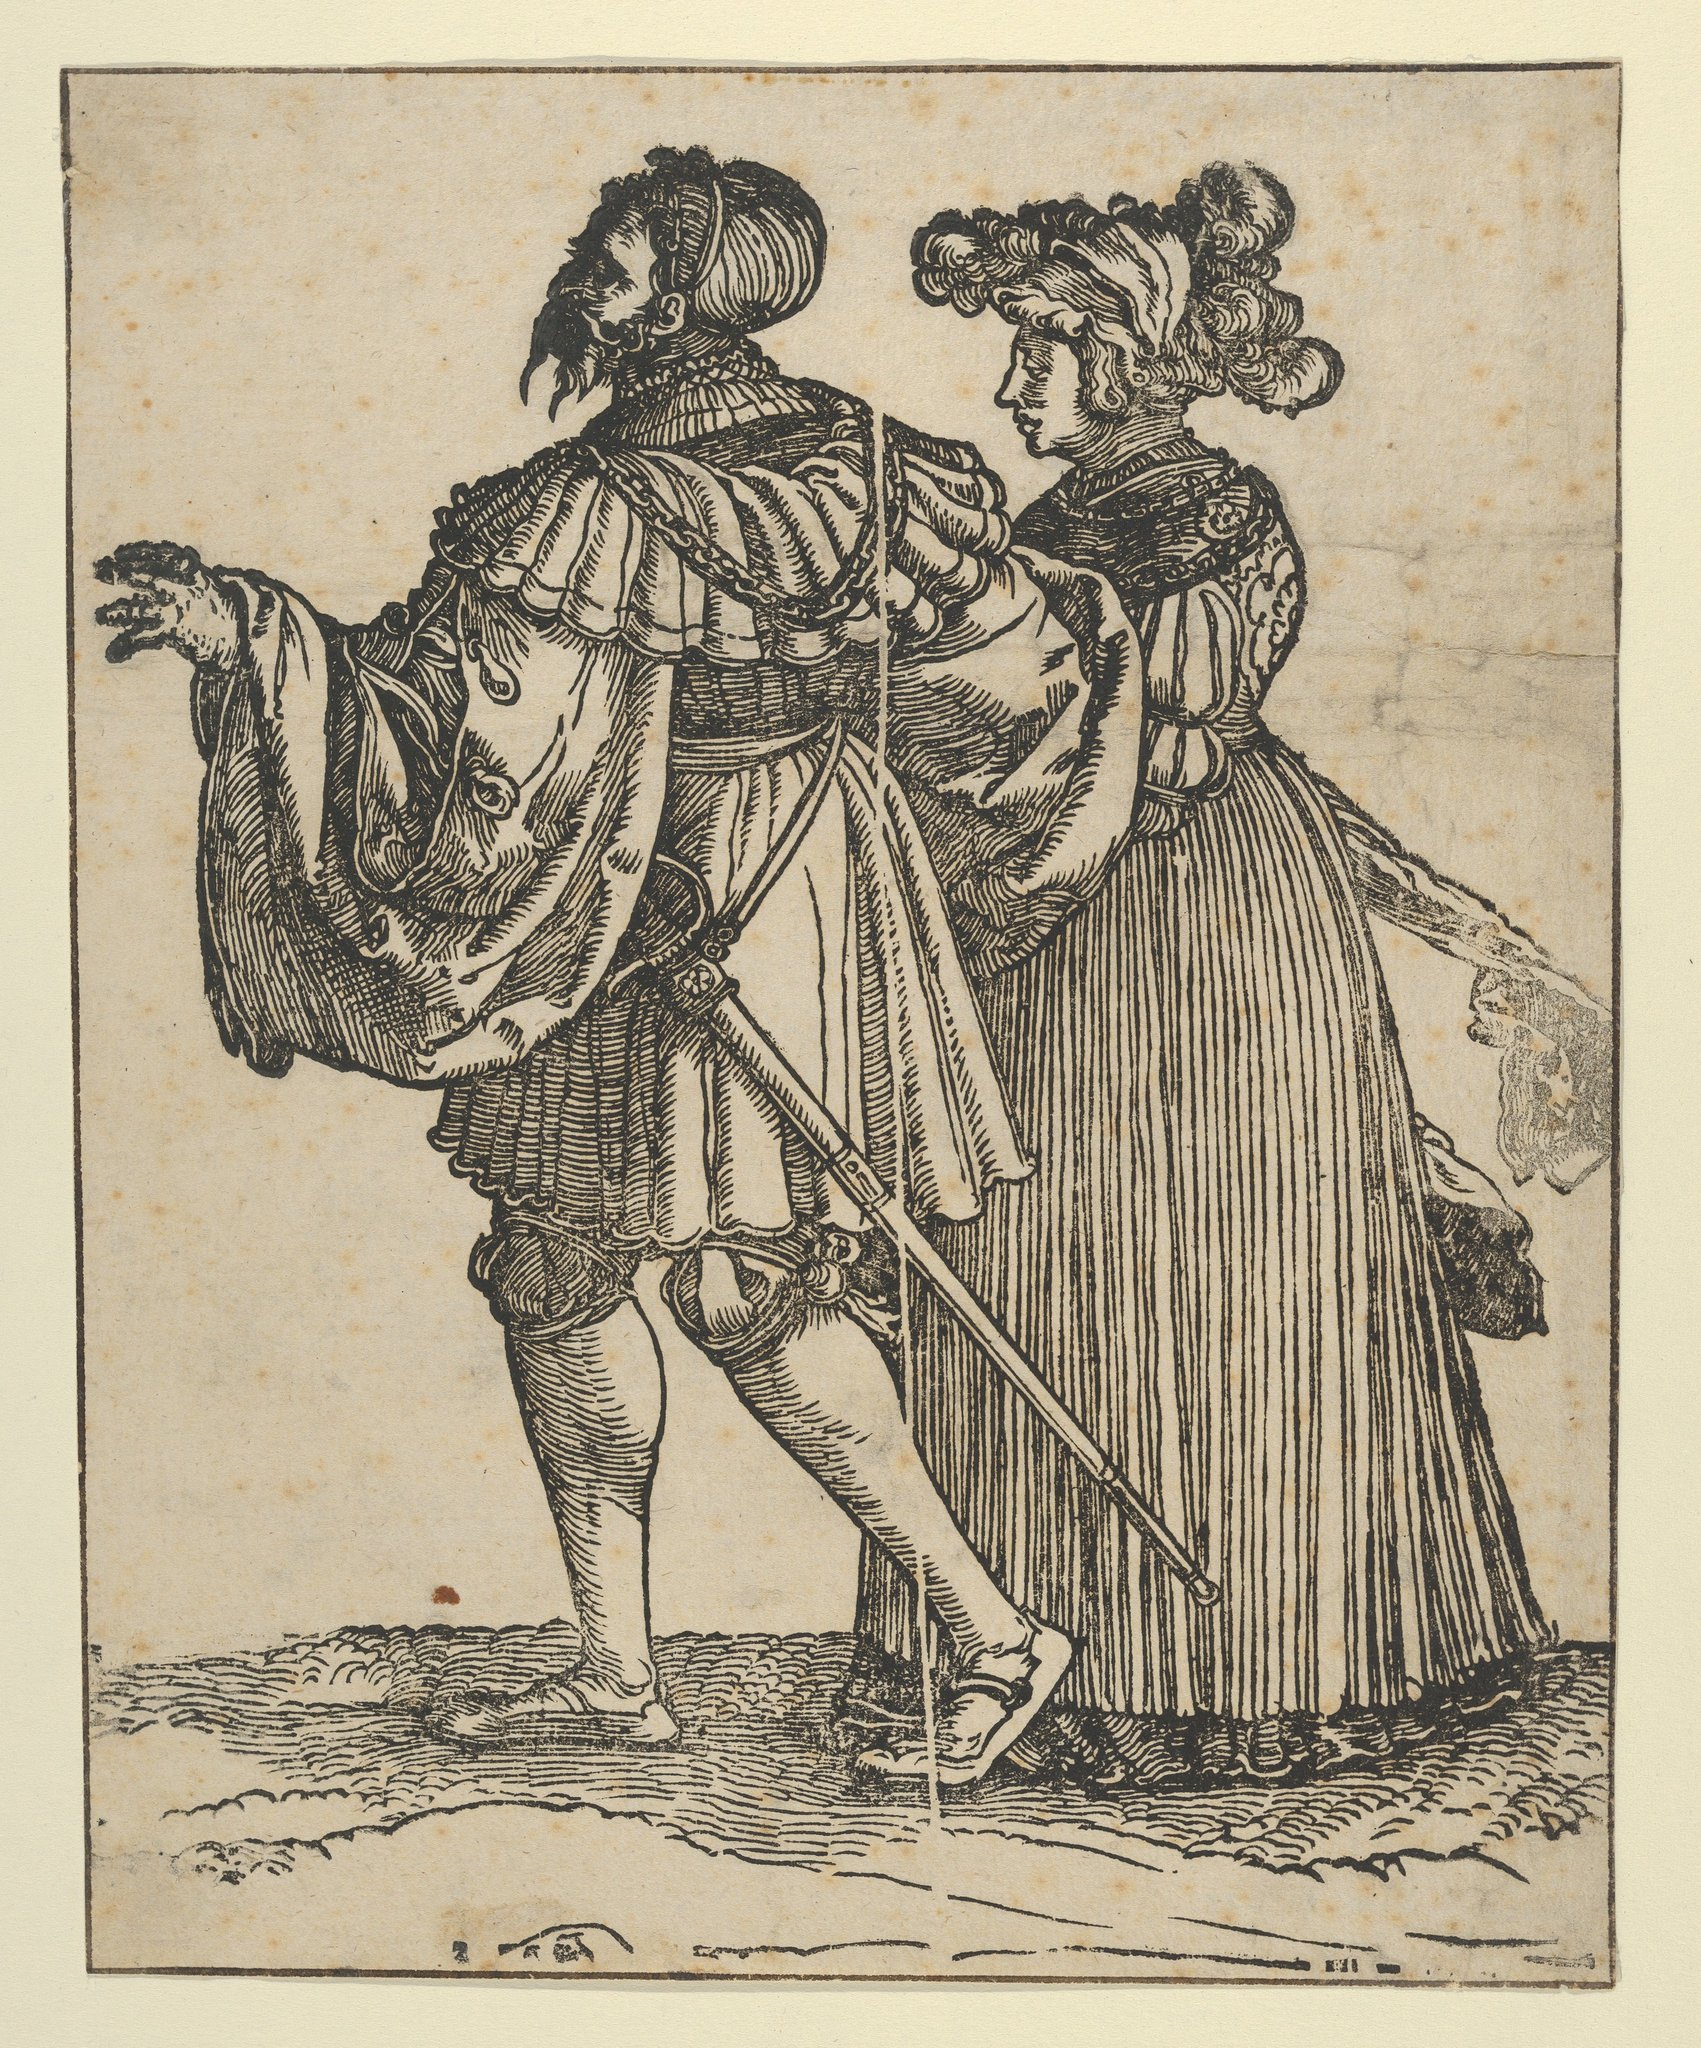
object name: print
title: Couple Walking to the Left (VI), from The Wedding Dancers (restrike)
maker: hans schäufelein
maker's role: artist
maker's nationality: german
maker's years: 1480-1540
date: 1500-1540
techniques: woodcut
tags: swords,couples,men,women,dancers